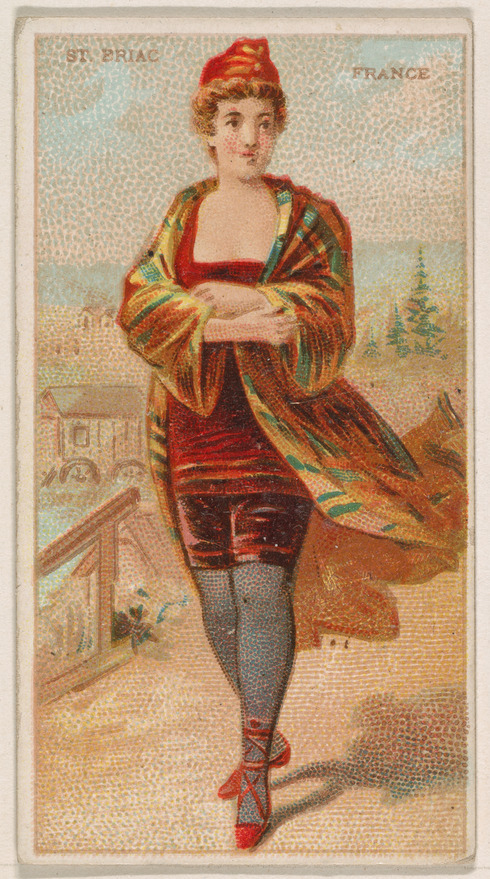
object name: print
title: St. Priac, France, from the Surf Beauties series (N232), issued by Kinney Bros.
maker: kinney brothers tobacco company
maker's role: publisher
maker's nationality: american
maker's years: 1869-2011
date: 1889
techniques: color lithograph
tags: women